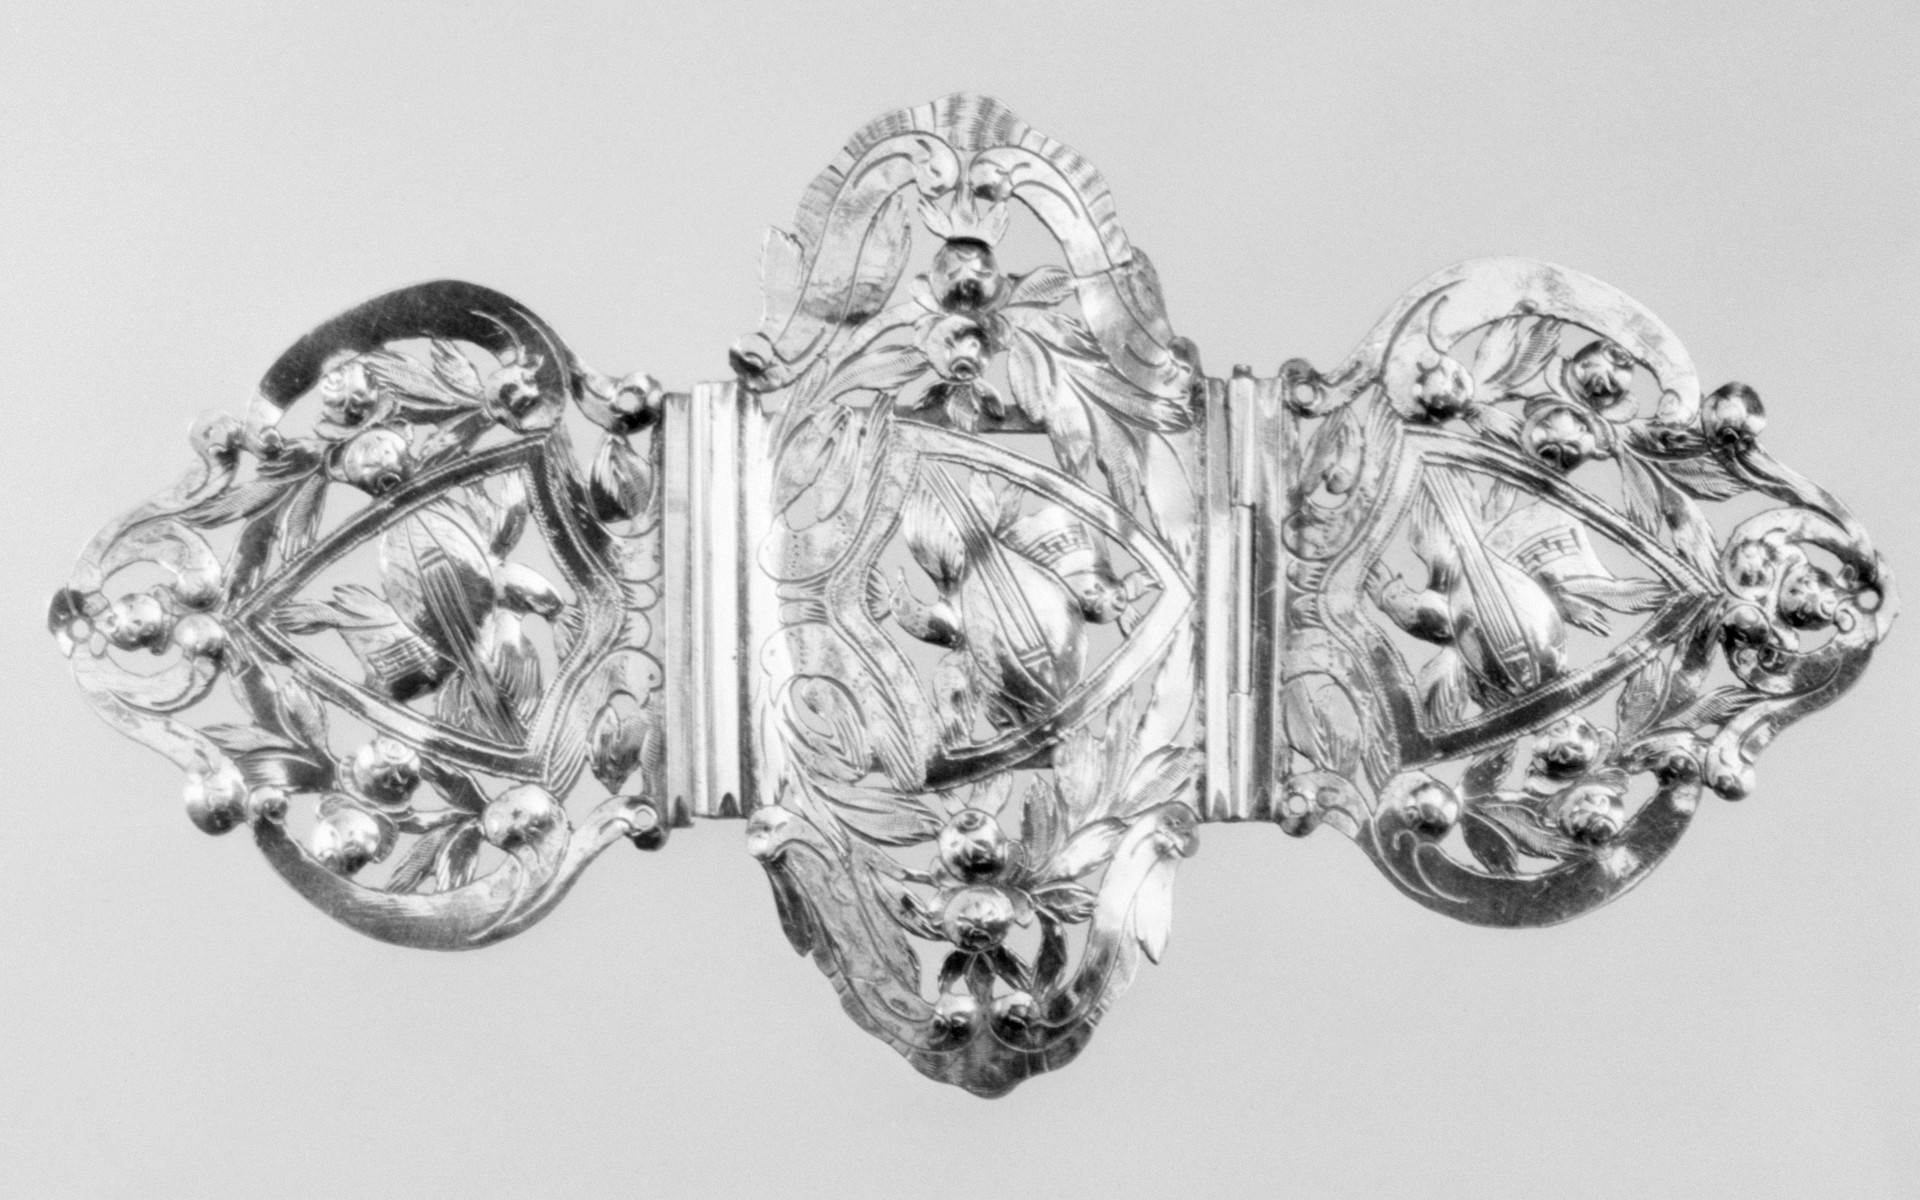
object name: book clasp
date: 1701-1800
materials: silver gilt